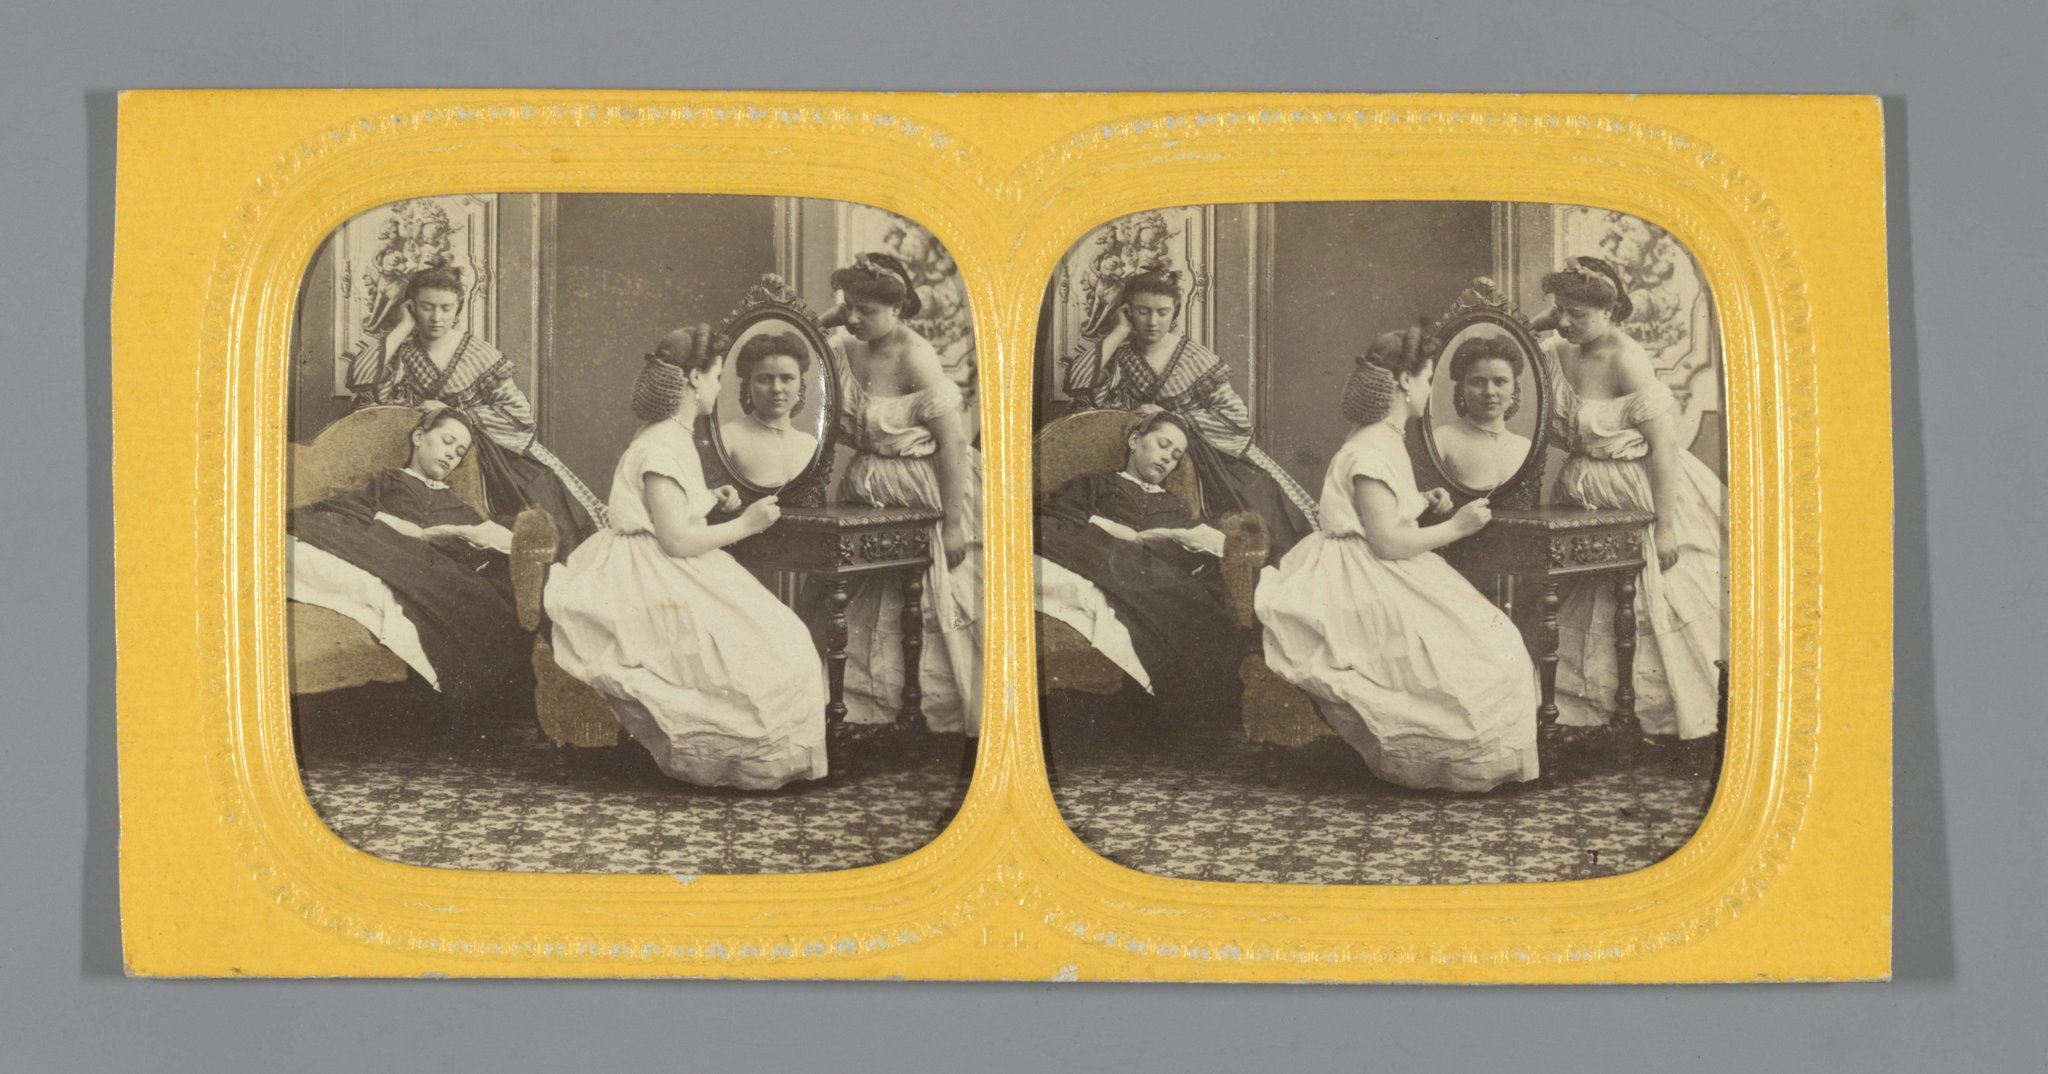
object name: tissue stereograph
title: Vier jonge vrouwen in boudoir, één kijkt in spiegel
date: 1855-1875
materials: cardboard, paper, photographic support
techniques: albumen print, cutting, hand coloring, perforating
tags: mirror